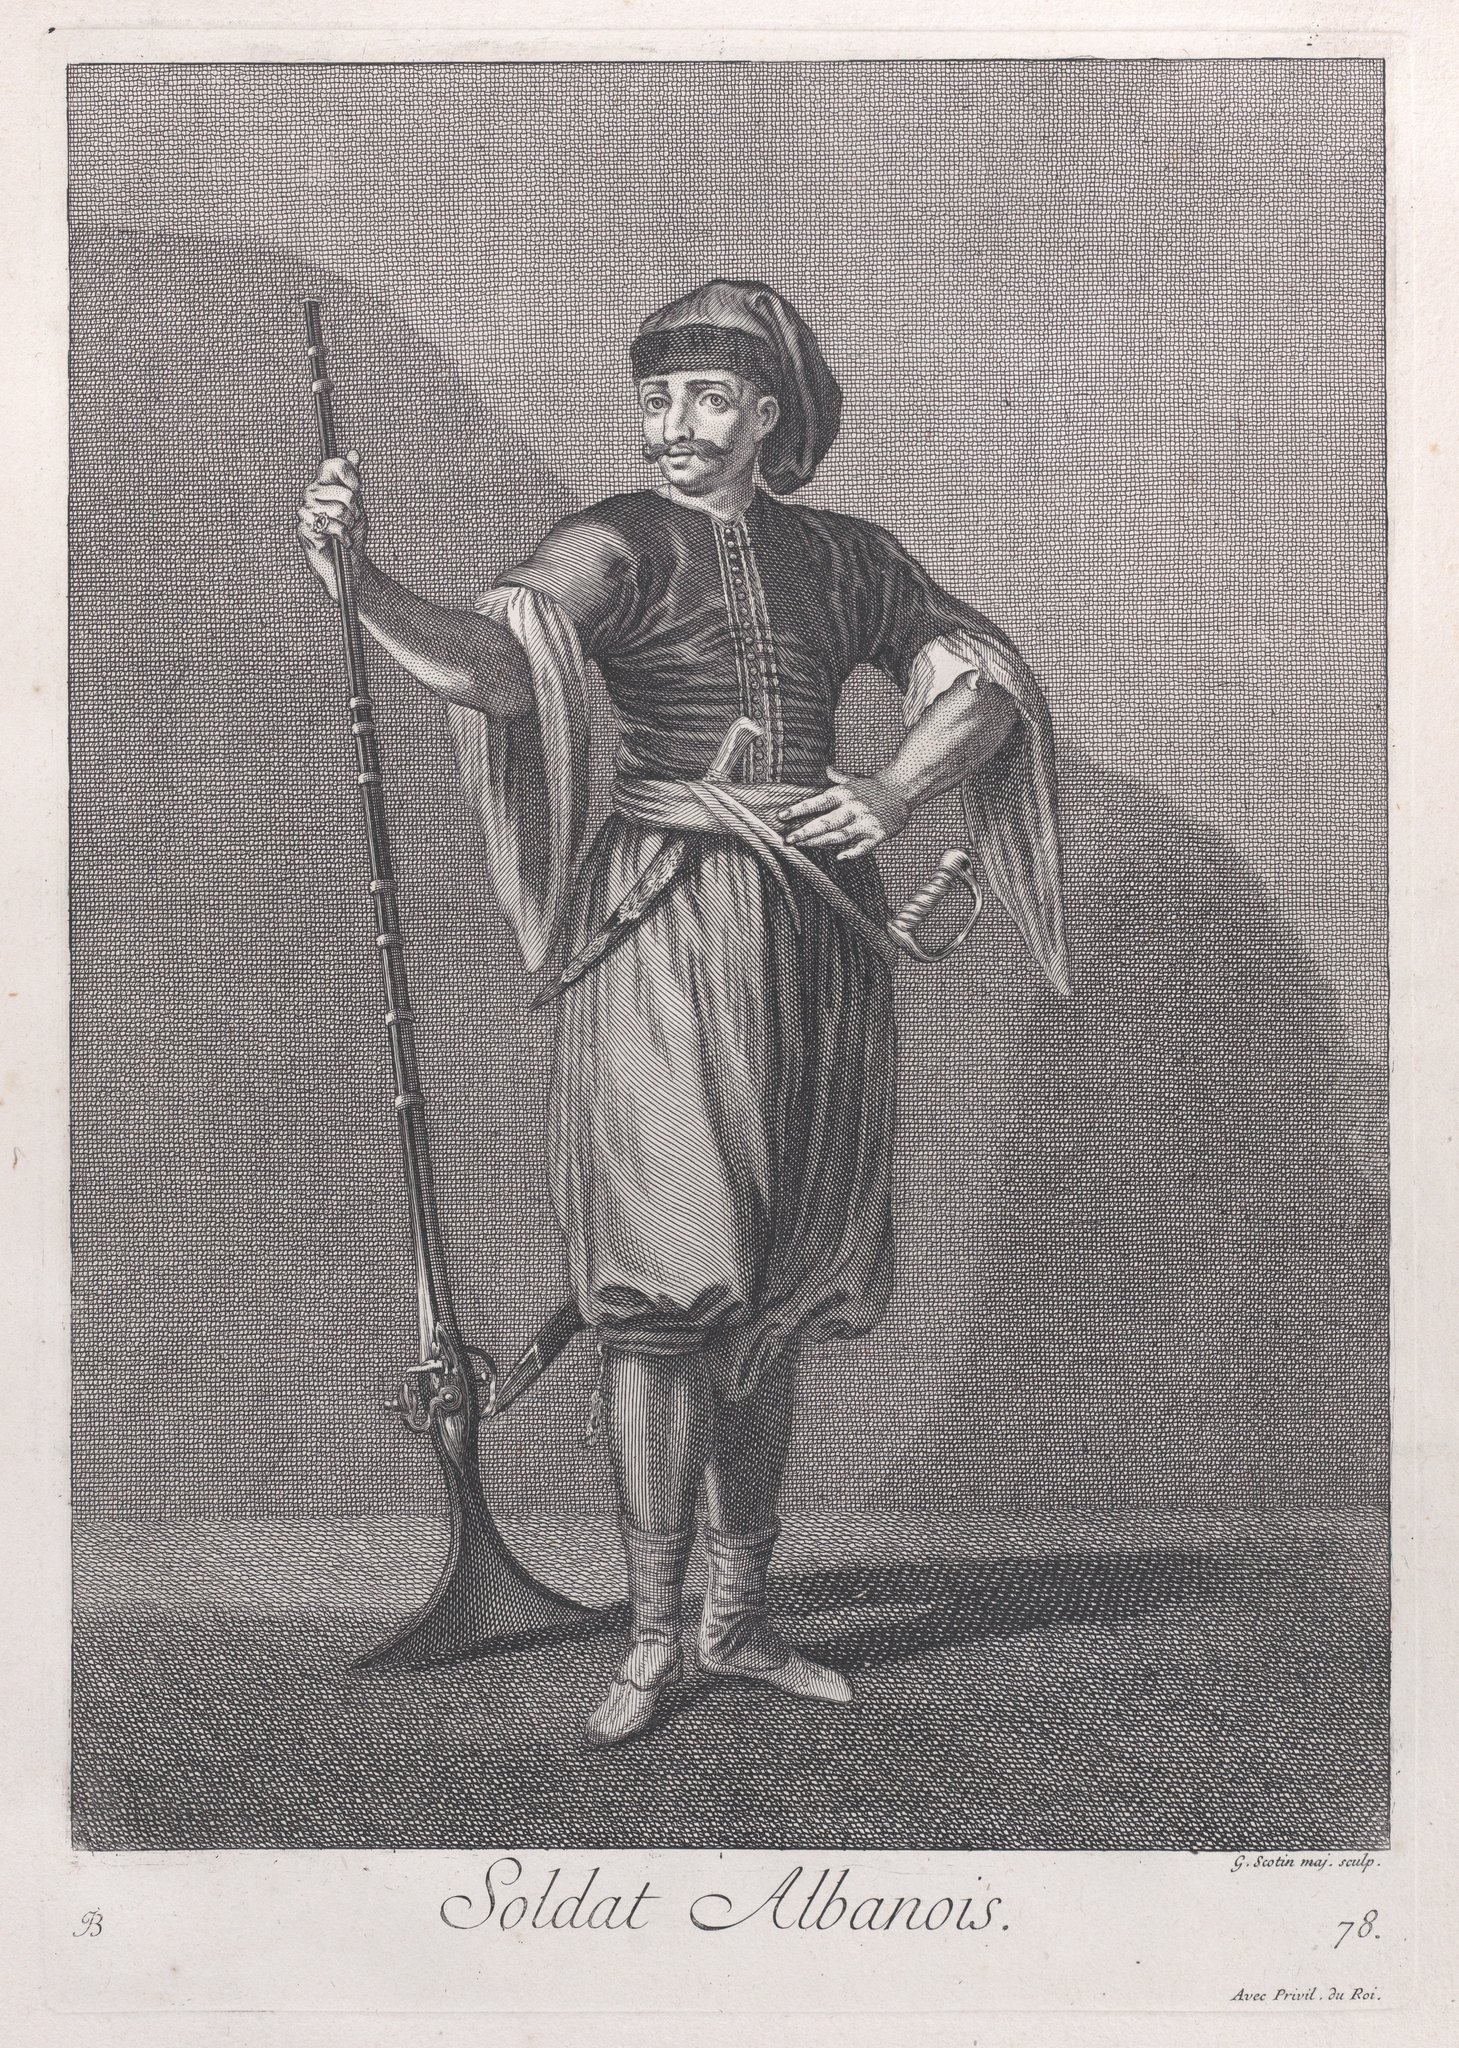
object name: print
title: Soldat Albanois, plate 78 from "Recueil de cent estampes représentent differentes nations du Levant"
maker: jean baptiste vanmour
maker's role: artist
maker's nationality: french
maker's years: 1671-1737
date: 1714-1715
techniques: engraving, etching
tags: soldiers,men